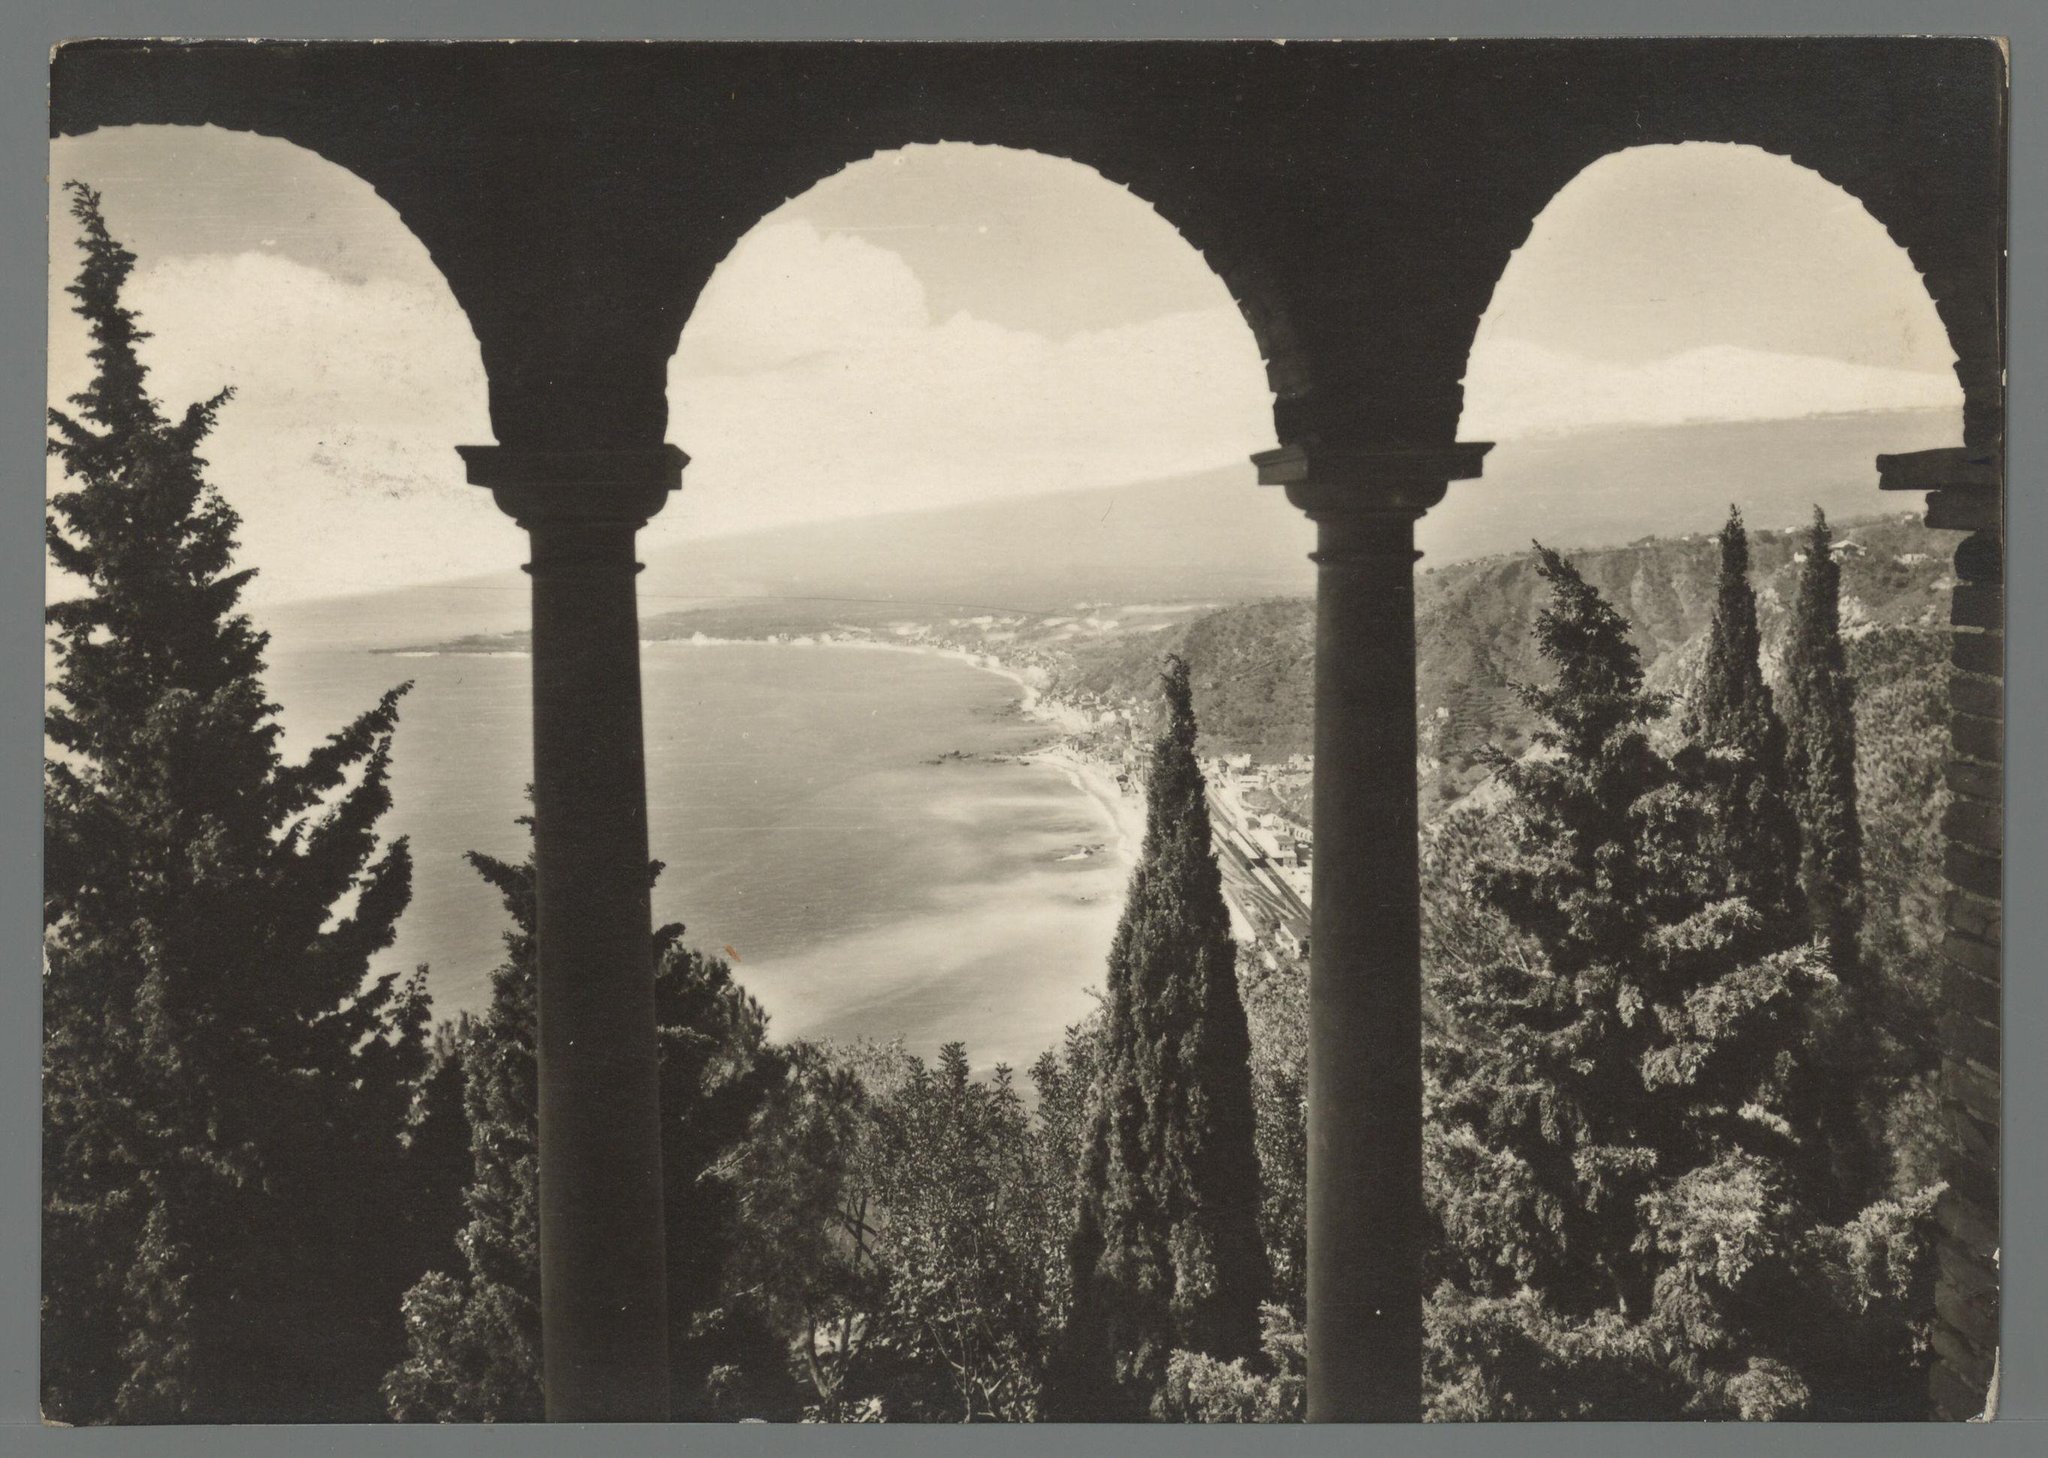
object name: photograph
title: Uitzicht op zee, vermoedelijk in Italië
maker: Anonymous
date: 1941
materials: photographic support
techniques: photography, writing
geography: terni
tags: sea (seascape), arcade ~ architecture, coast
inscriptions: postage stamp